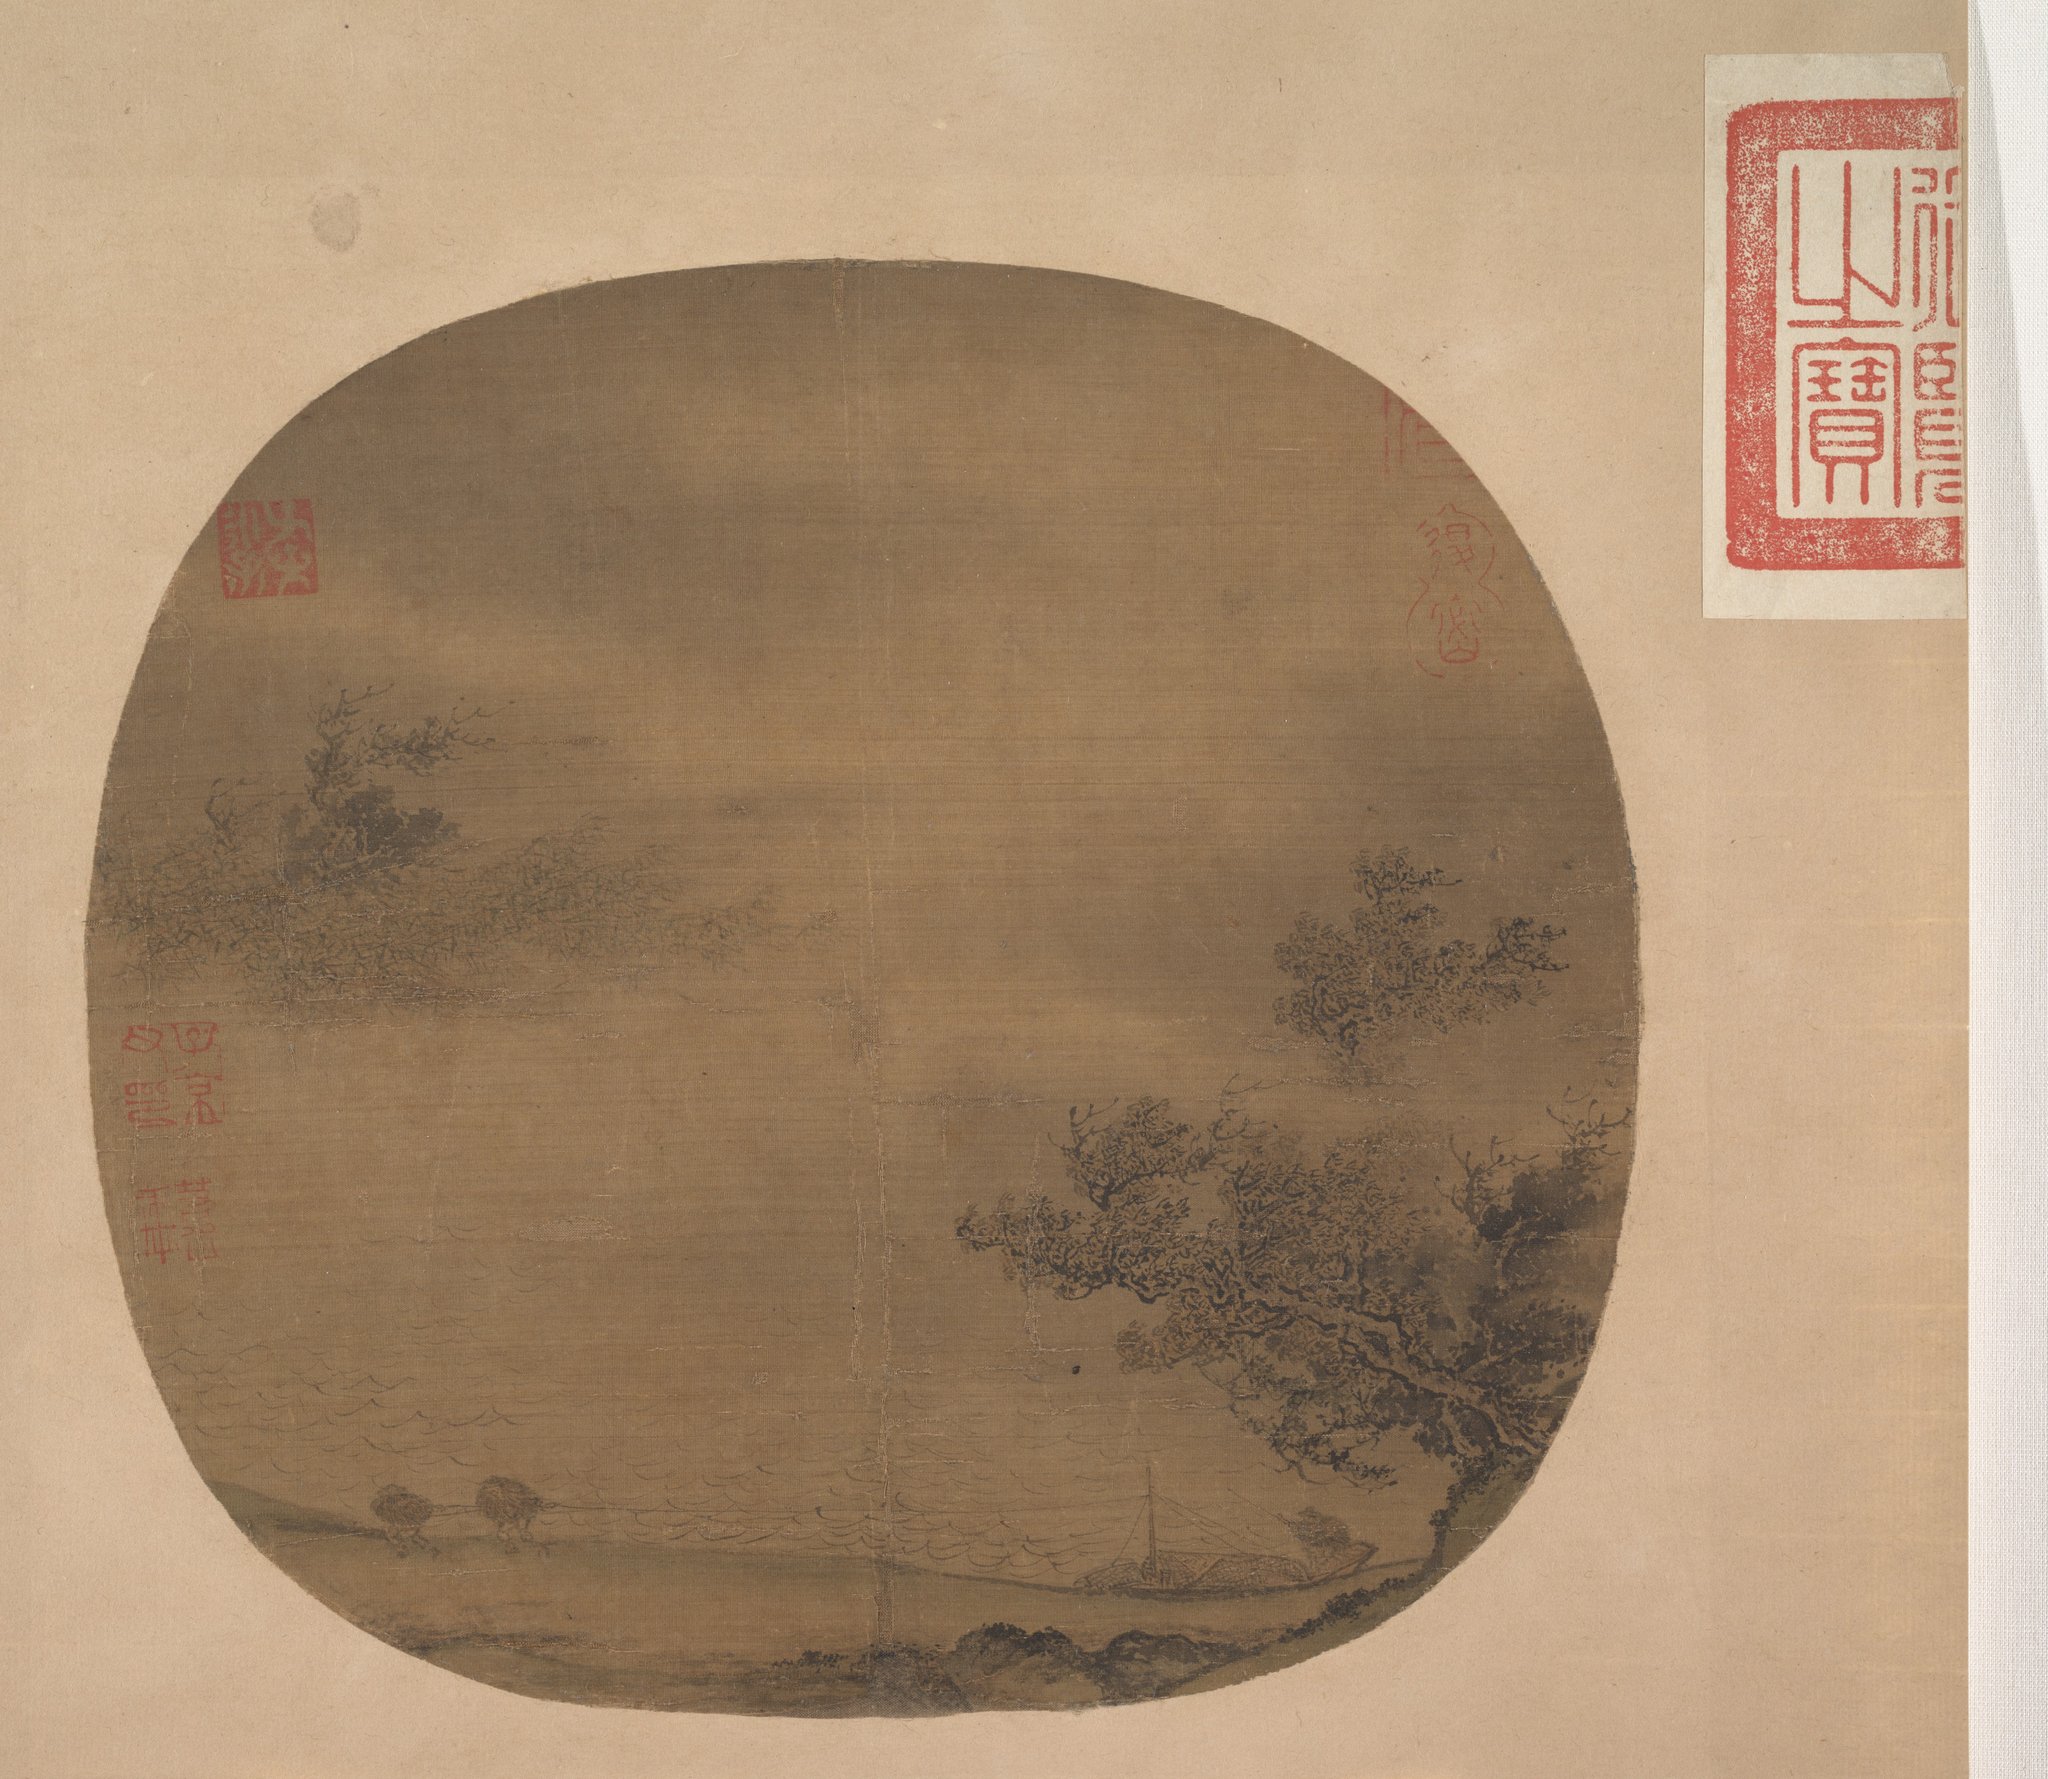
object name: fan mounted a an album leaf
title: Towing a Boat in a Rainstorm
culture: chinese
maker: unidentified artist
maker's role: artist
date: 1167-1200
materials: ink, silk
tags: landscapes,storms,boats